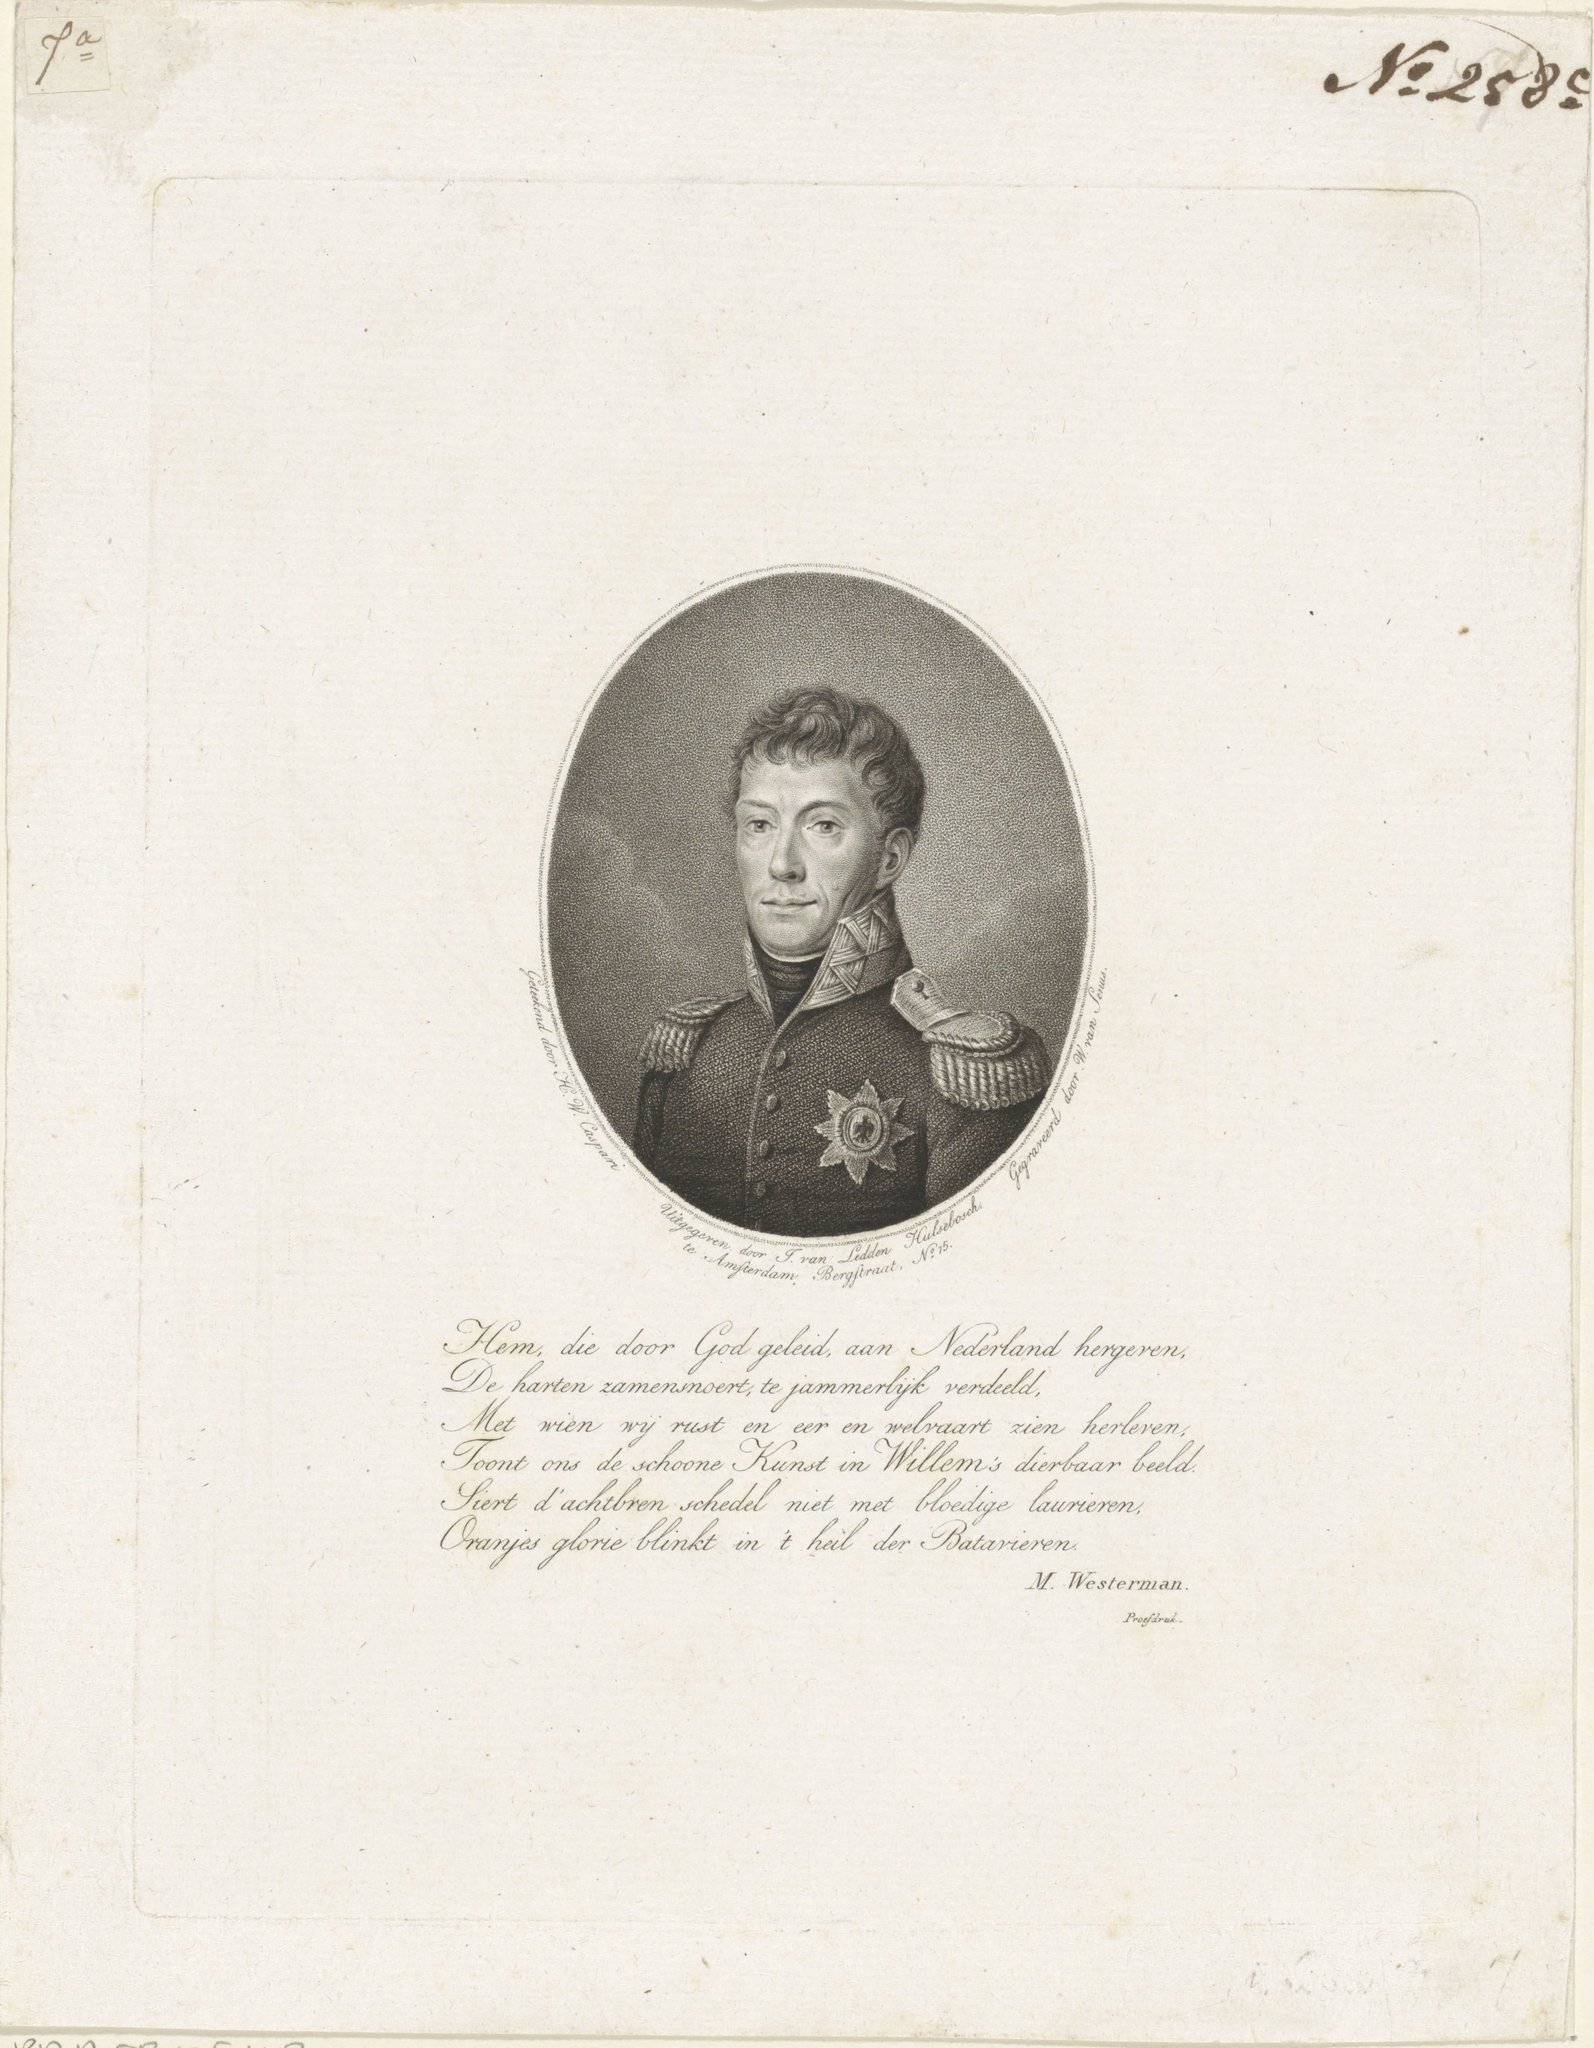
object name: print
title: Portret van Willem I Frederik, koning der Nederlanden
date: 1813-1819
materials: paper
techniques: engraving, etching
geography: netherlands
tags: the hague, berlin, william i of the netherlands, knighthood order (with name) - insignia of a knighthood order, e.g.: badge, chain (with name of order)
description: De hier vermelde titel verwijst naar de hoogst verkregen titel van de geportretteerde, niet per se naar de titel die de geportretteerde op deze voorstelling draagt.